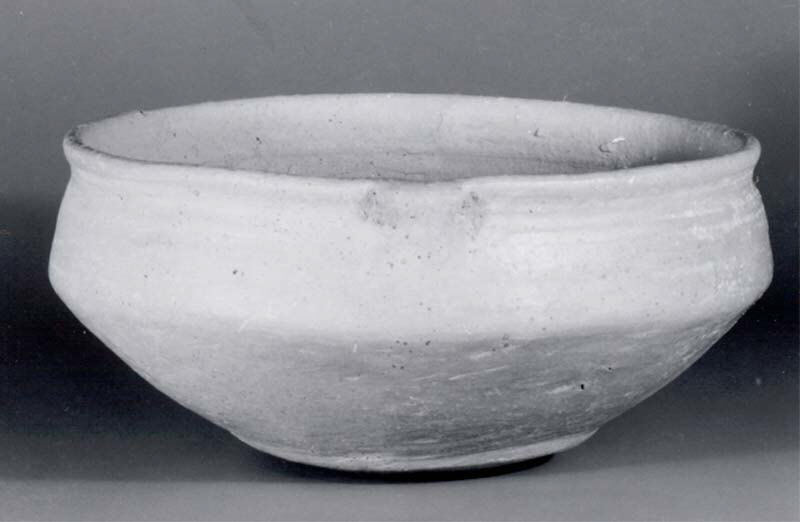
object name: bowl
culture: iranian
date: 1000-801 BCE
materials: ceramic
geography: iran